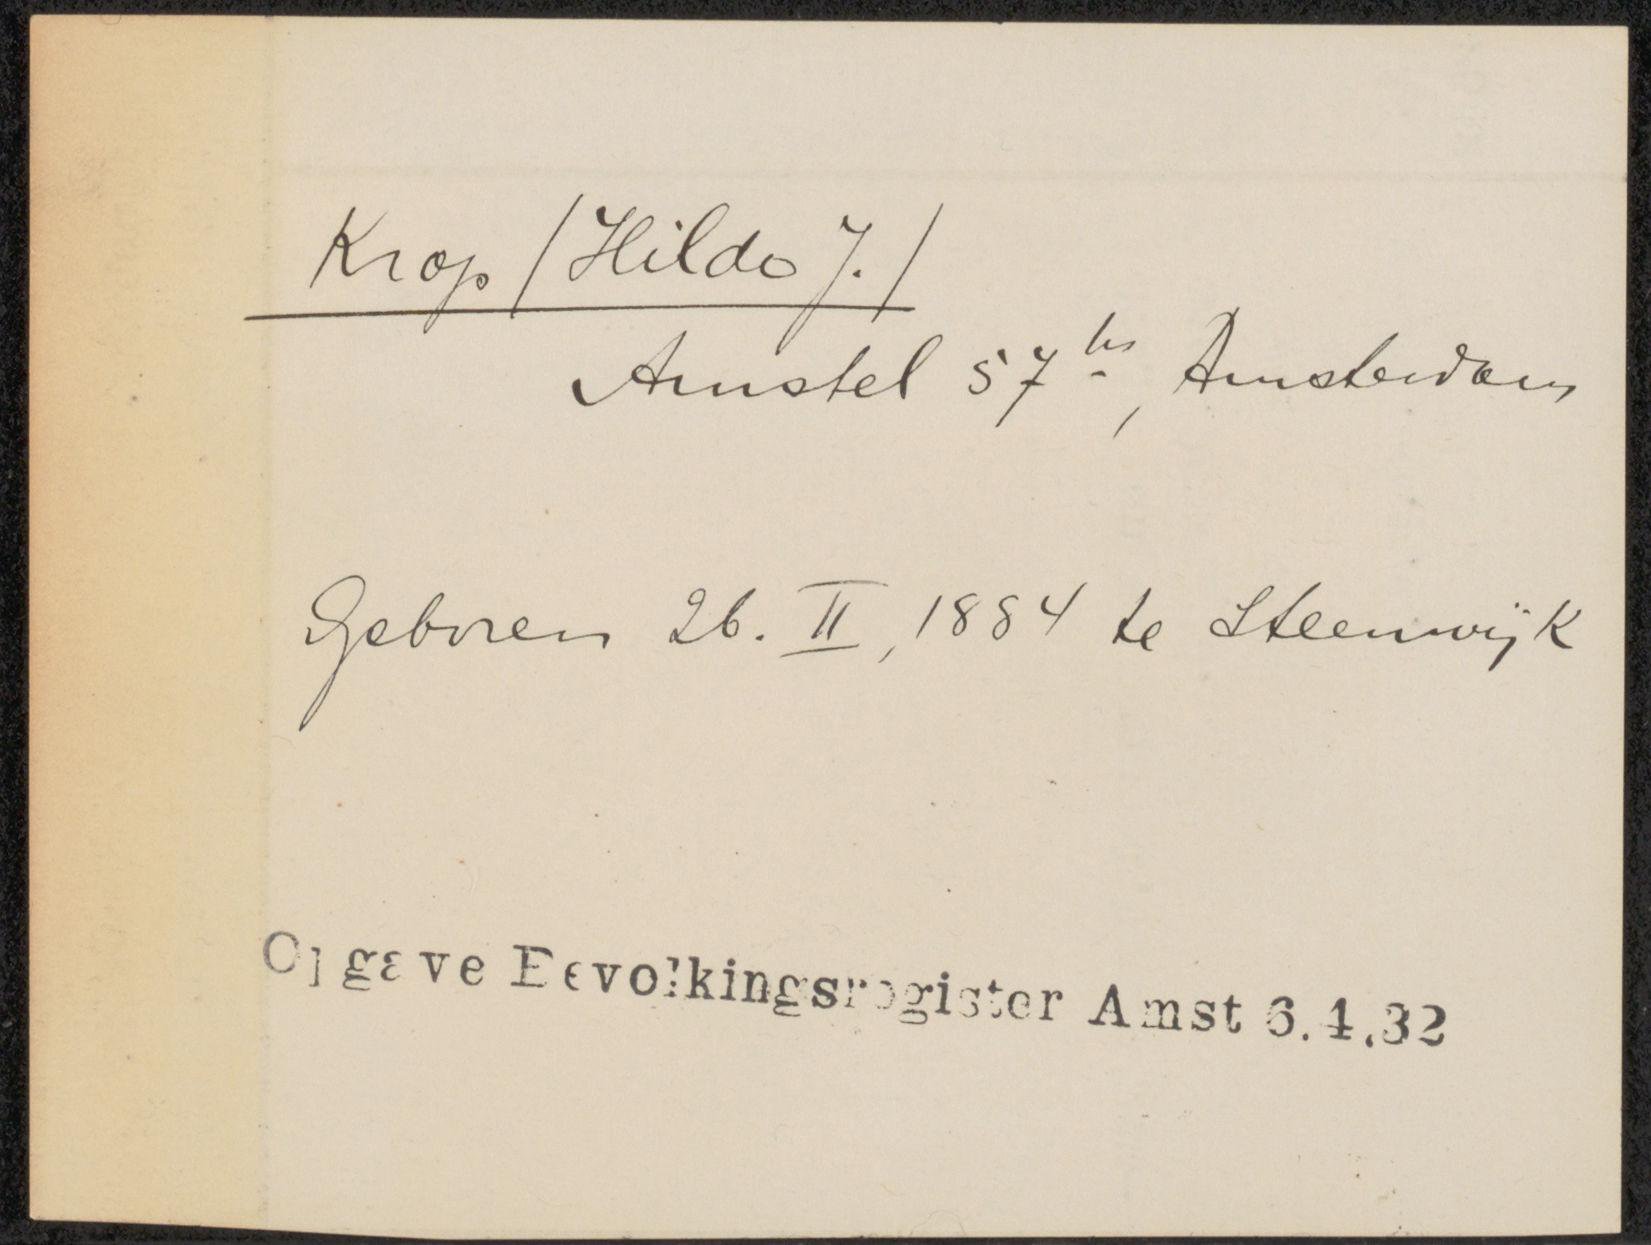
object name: aantekening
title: Aantekening betreffende Hildo Krop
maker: Anonymous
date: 1932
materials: ink, paper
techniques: pen, writing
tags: amsterdam, print maker, draughtsman, sculptor, hildo krop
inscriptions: stamp: ‘Opgave Bevolkingsregister Amst 6.4.32’